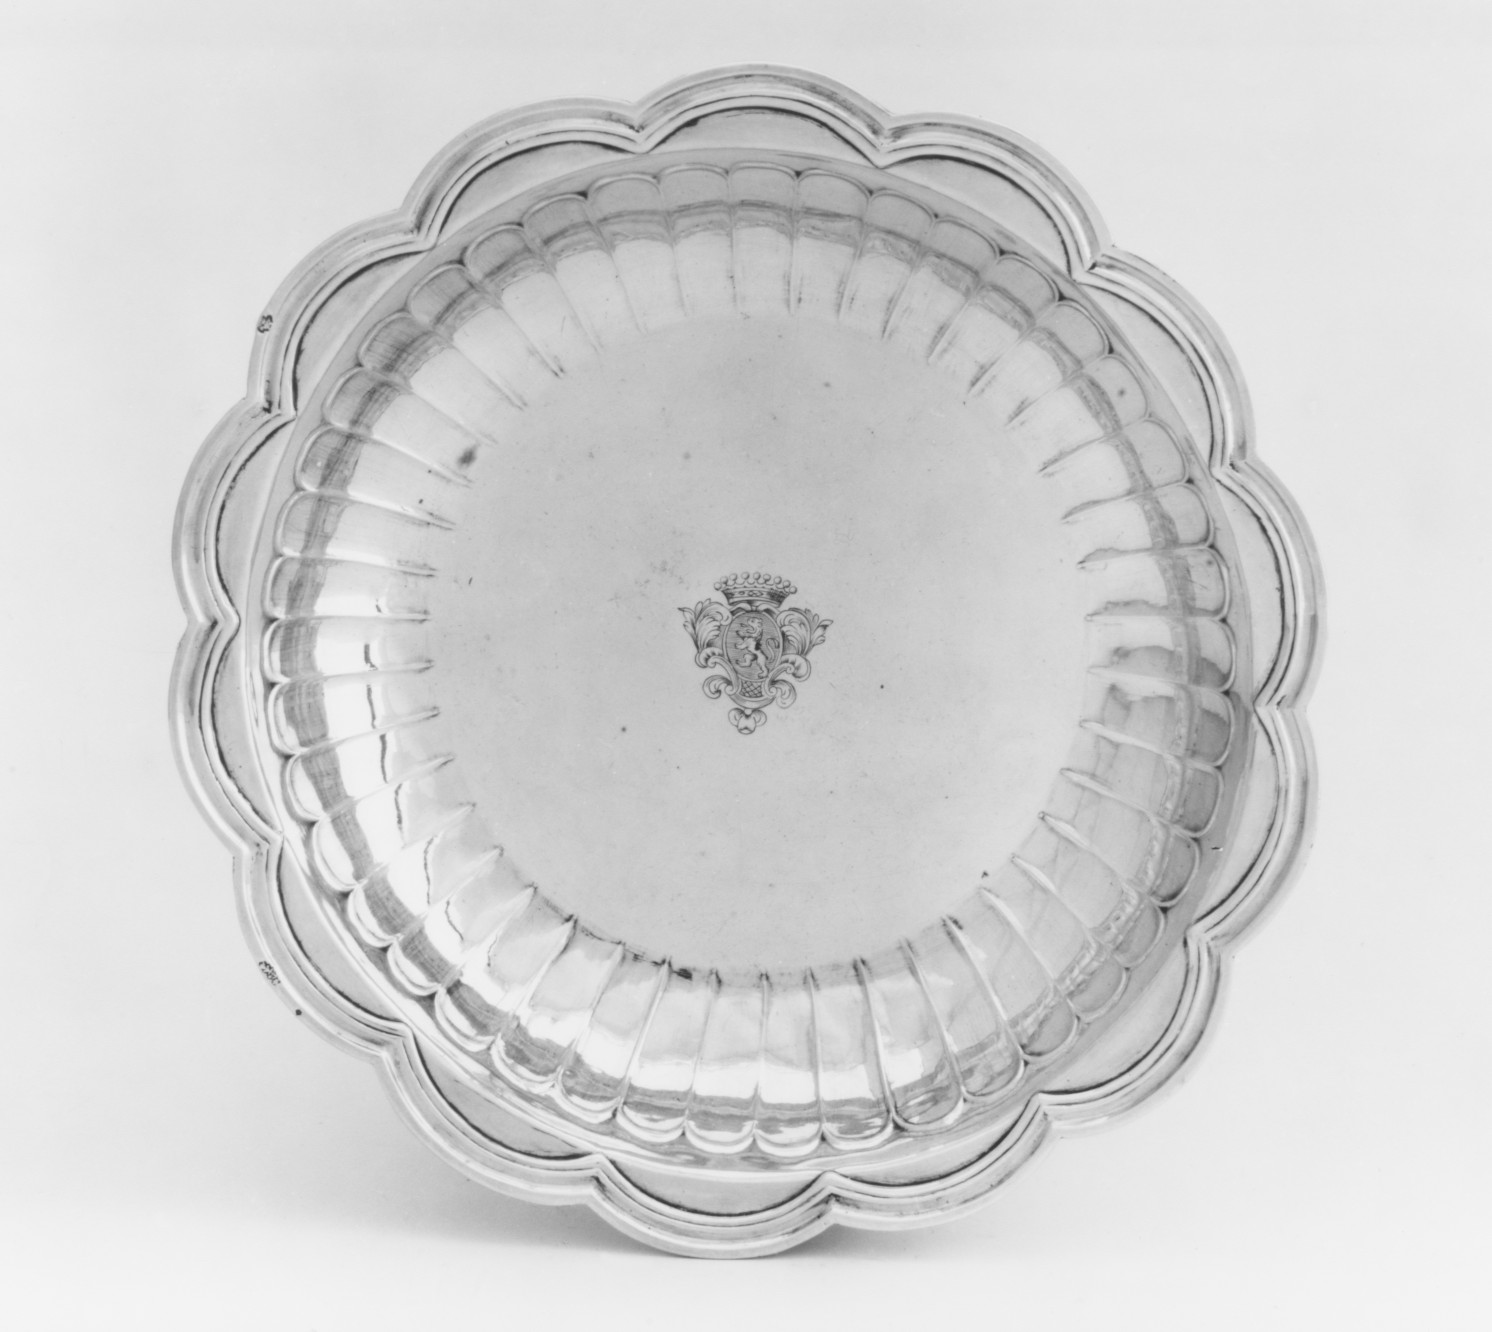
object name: dish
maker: philippe-jacques langlois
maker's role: maker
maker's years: 1678-1772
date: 1728-1729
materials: silver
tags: coat of arms